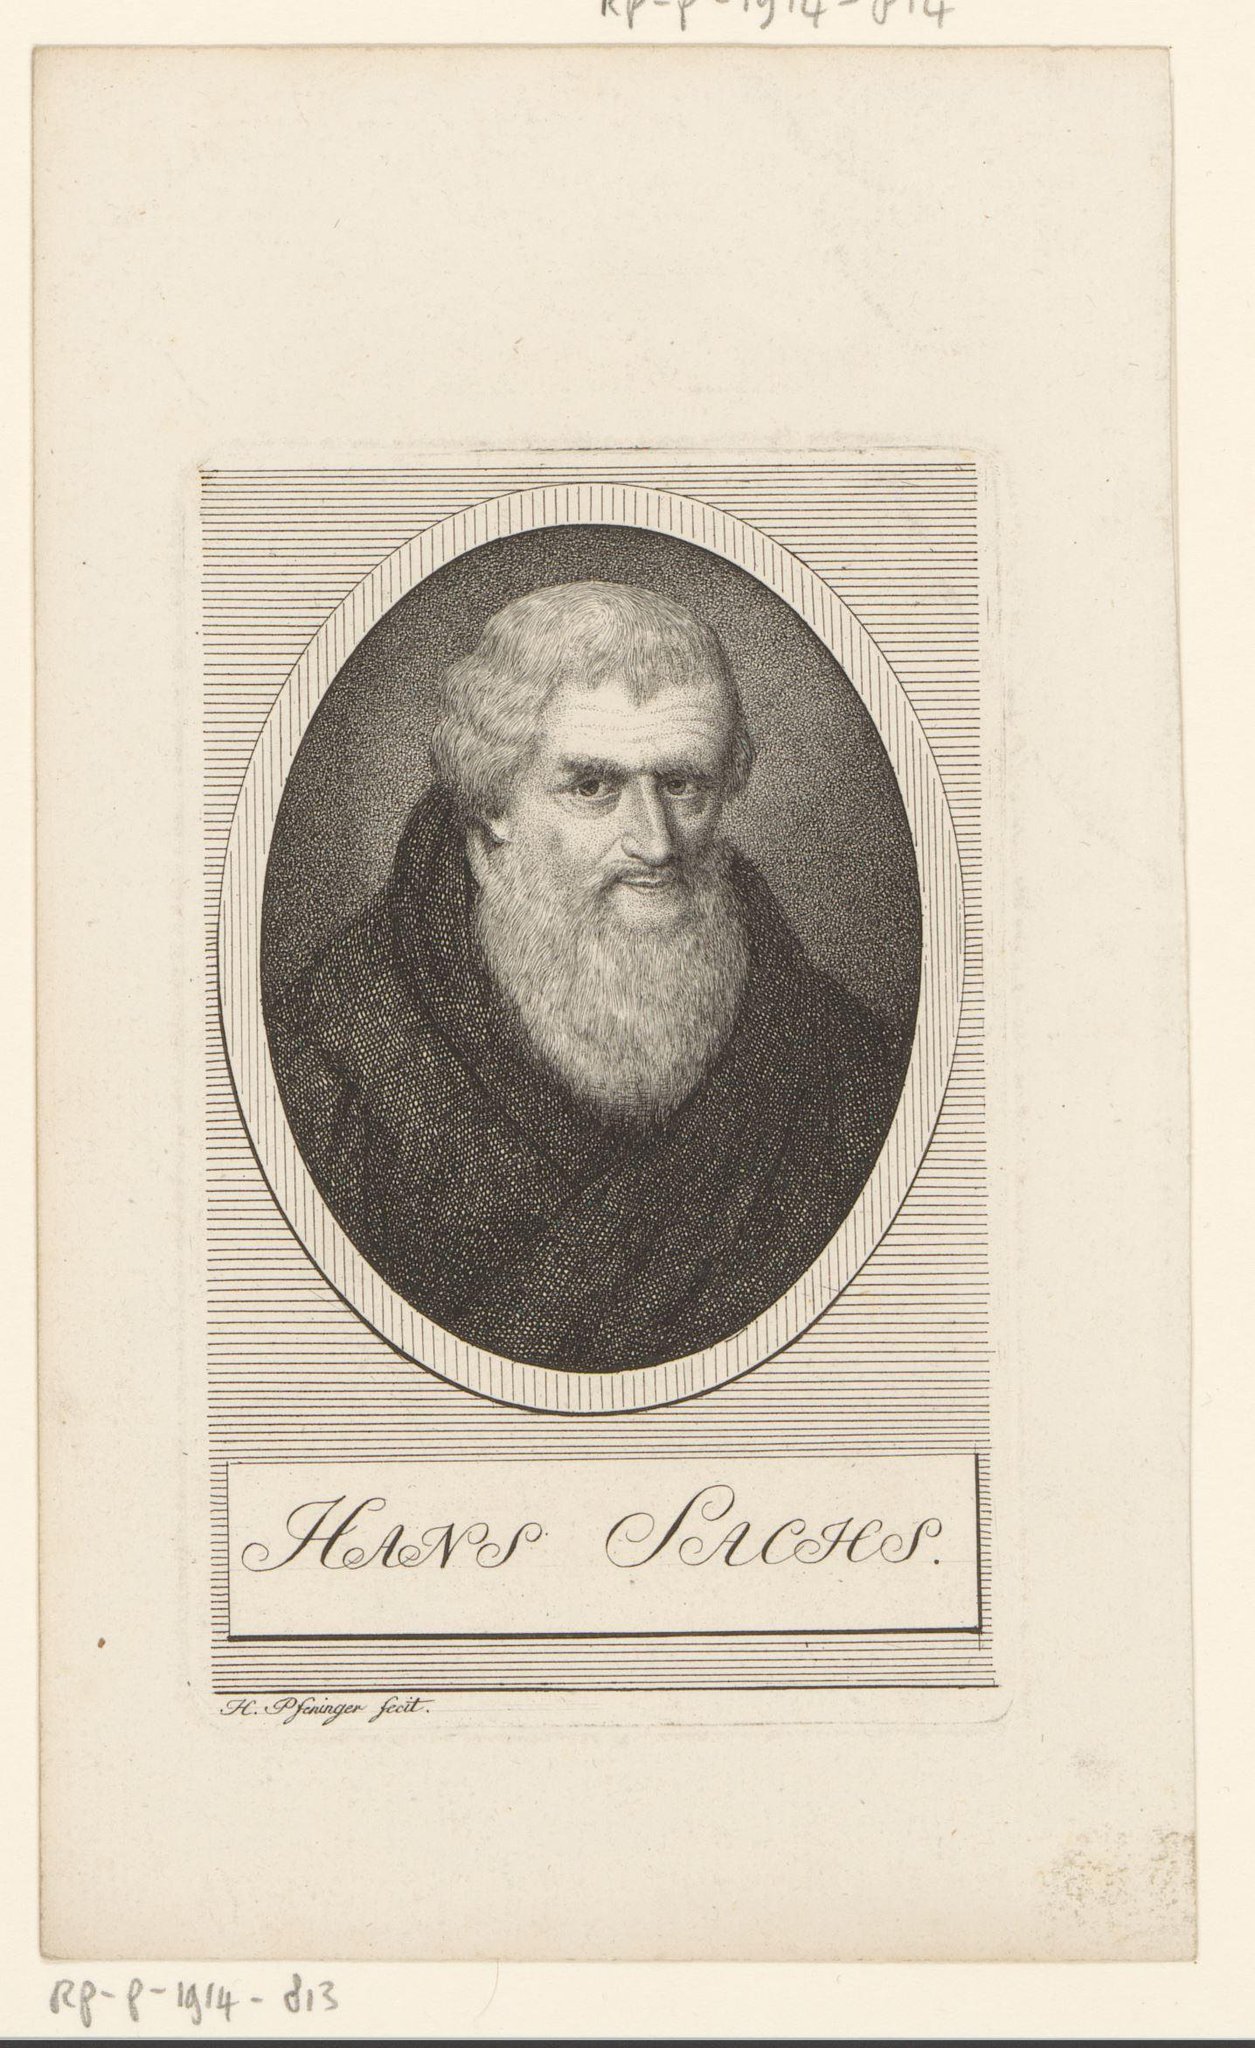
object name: print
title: Portret van Hans Sachs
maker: heinrich pfenninger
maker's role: print maker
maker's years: 1749-1815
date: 1759-1815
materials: paper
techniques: etching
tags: hans sachs, historical persons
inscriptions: collector's mark: Lugt 2228